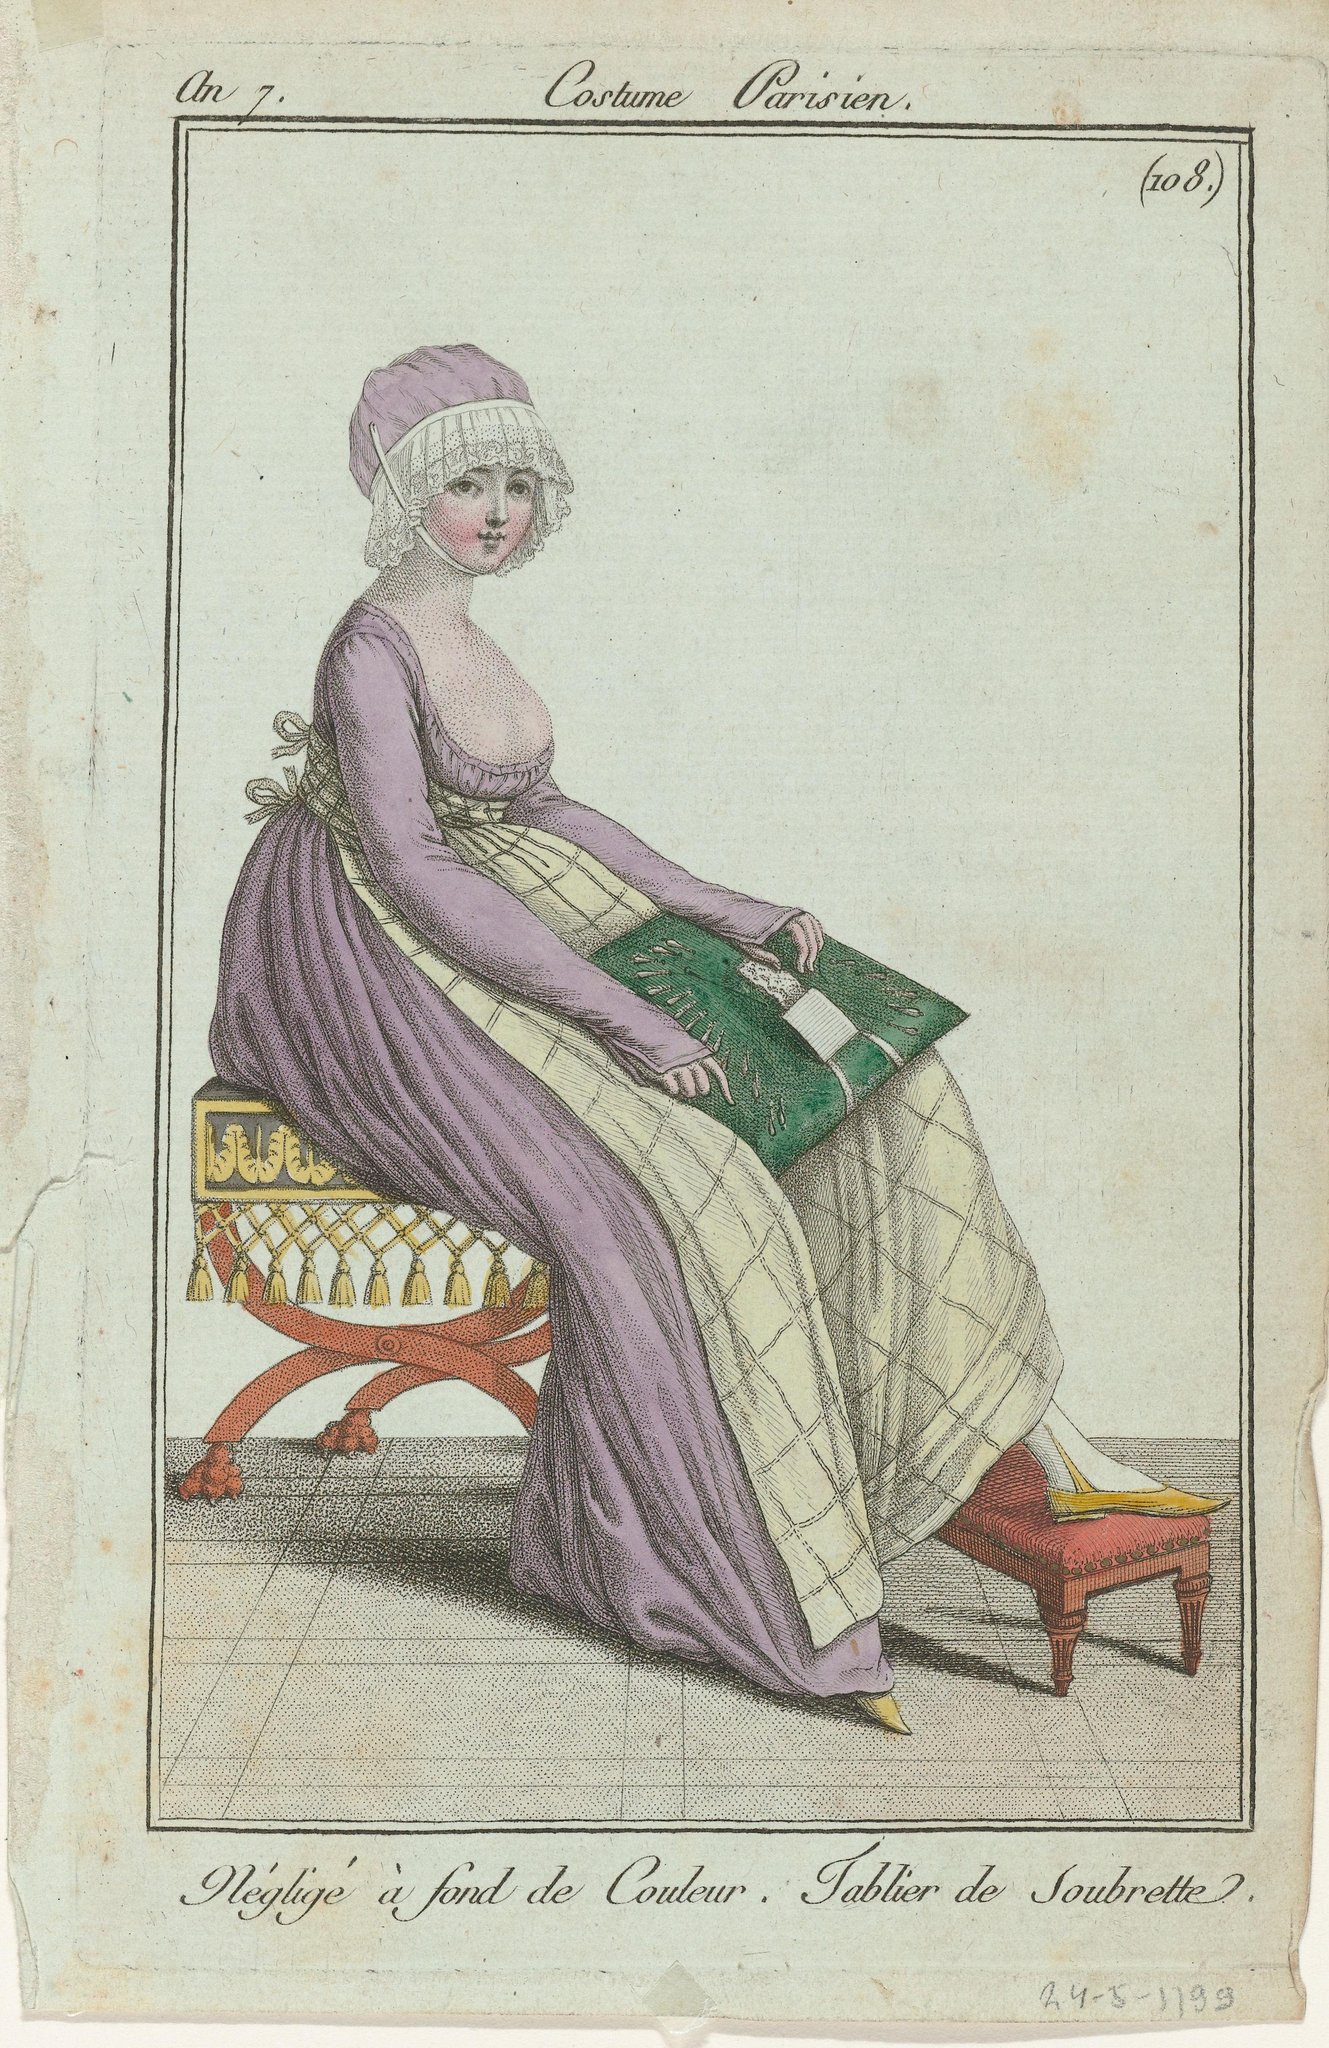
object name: fashion print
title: Journal des Dames et des Modes, Costume Parisien, 24 mai 1799, An 7, (108(bis)) : Négligé à fond de Couleur (...)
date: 1799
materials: paper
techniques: engraving, hand coloring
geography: paris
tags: footstool, head-gear: cap (+ women's clothes), 'décolleté', fashion plates, shoes, sandals (+ women's clothes), dress, gown (+ women's clothes), stool, stockings, socks (+ women's clothes), apron (+ women's clothes)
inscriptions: title: ‘Costume Parisien.’, caption: ‘Négligé à fond de Couleur. Tablier de Soubrette.’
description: Vrouw, zittend op een taboeret en voetenbankje, met handwerk (kantklossen) op schoot., Zij is gekleed in 'négligé à fond de couleur' ofwel een paarse japon met lange mouwen, decolleté en hoge taille. Hierop een geruit (sier)schort of 'tablier de Soubrette'. Witte kous met gekleurde klink. Verdere accessoires: muts met band onder de kin, platte schoenen met puntige neuzen. De prent maakt deel uit van het modetijdschrift Journal des Dames et des Modes, uitgegeven door Sellèque, Parijs, 1797-1839.